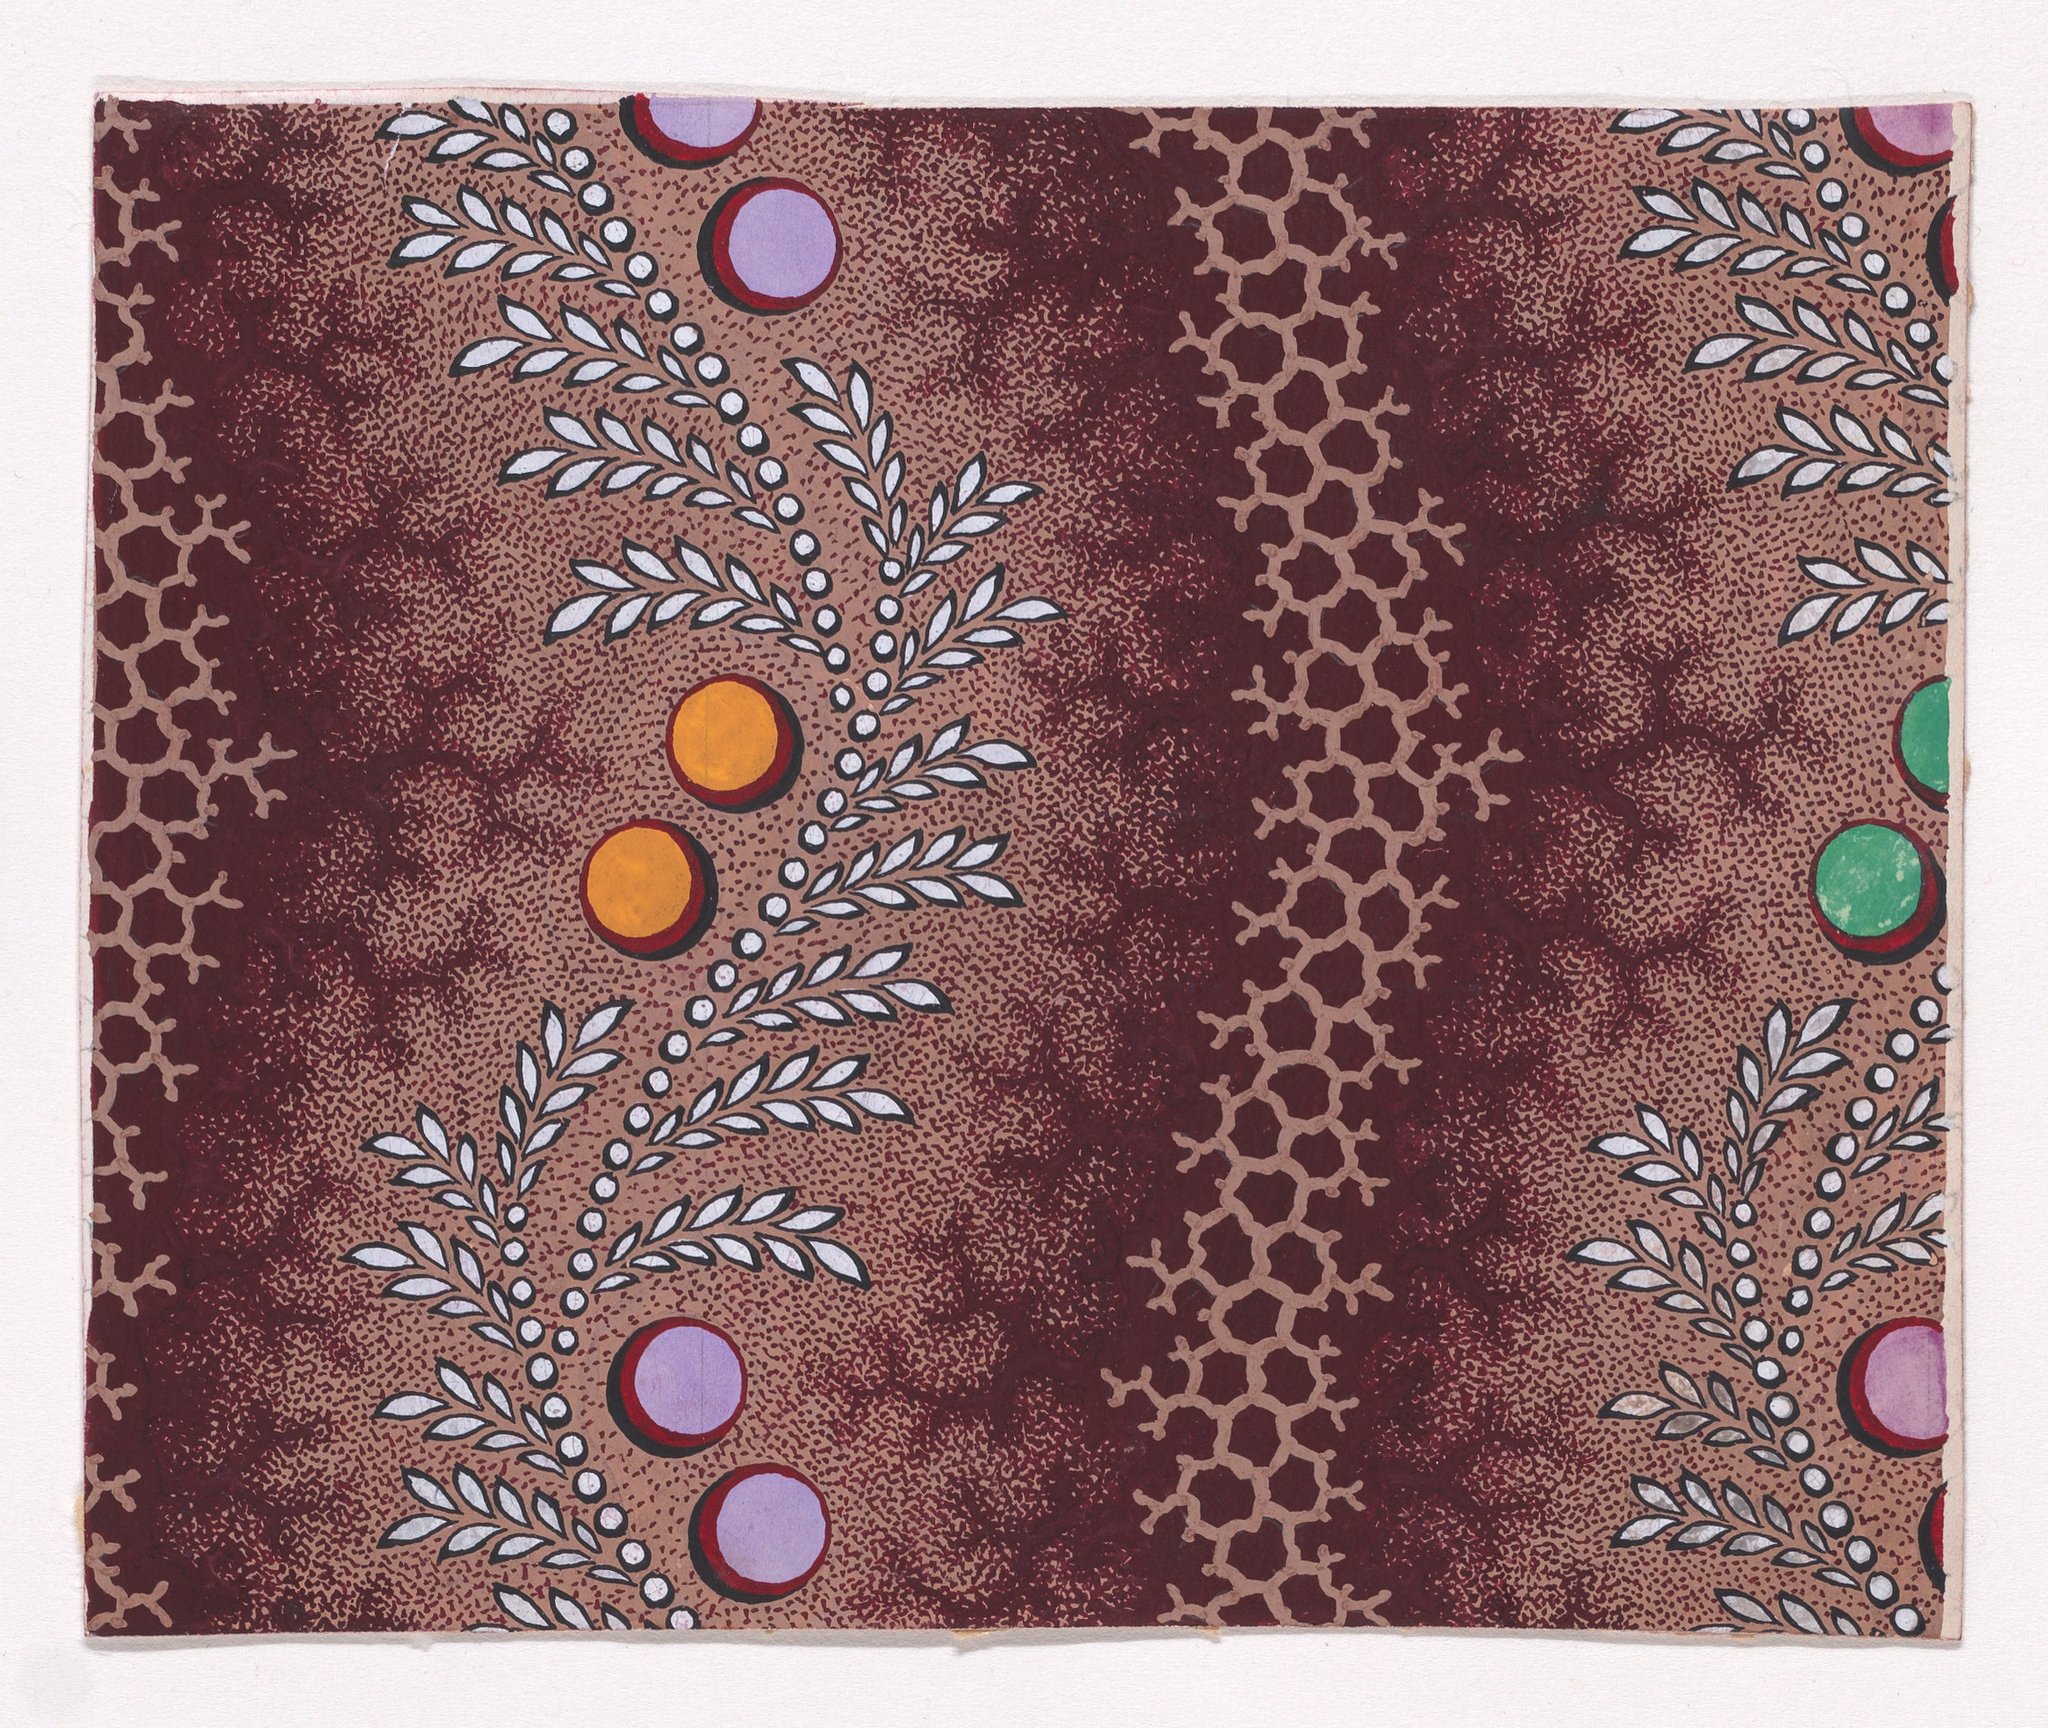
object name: drawing ornament architecture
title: Textile Design with Alternating Vertical Strips of Undulating Honeycomb Pattern with Branch Offsets and Undulating Garlands of Pearls with Alternating Offsetting Wheat Ears and Pairs of Circles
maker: anonymous, alsatian, 19th century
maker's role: artist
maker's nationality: alsatian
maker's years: 1800-1900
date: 1840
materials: gouache